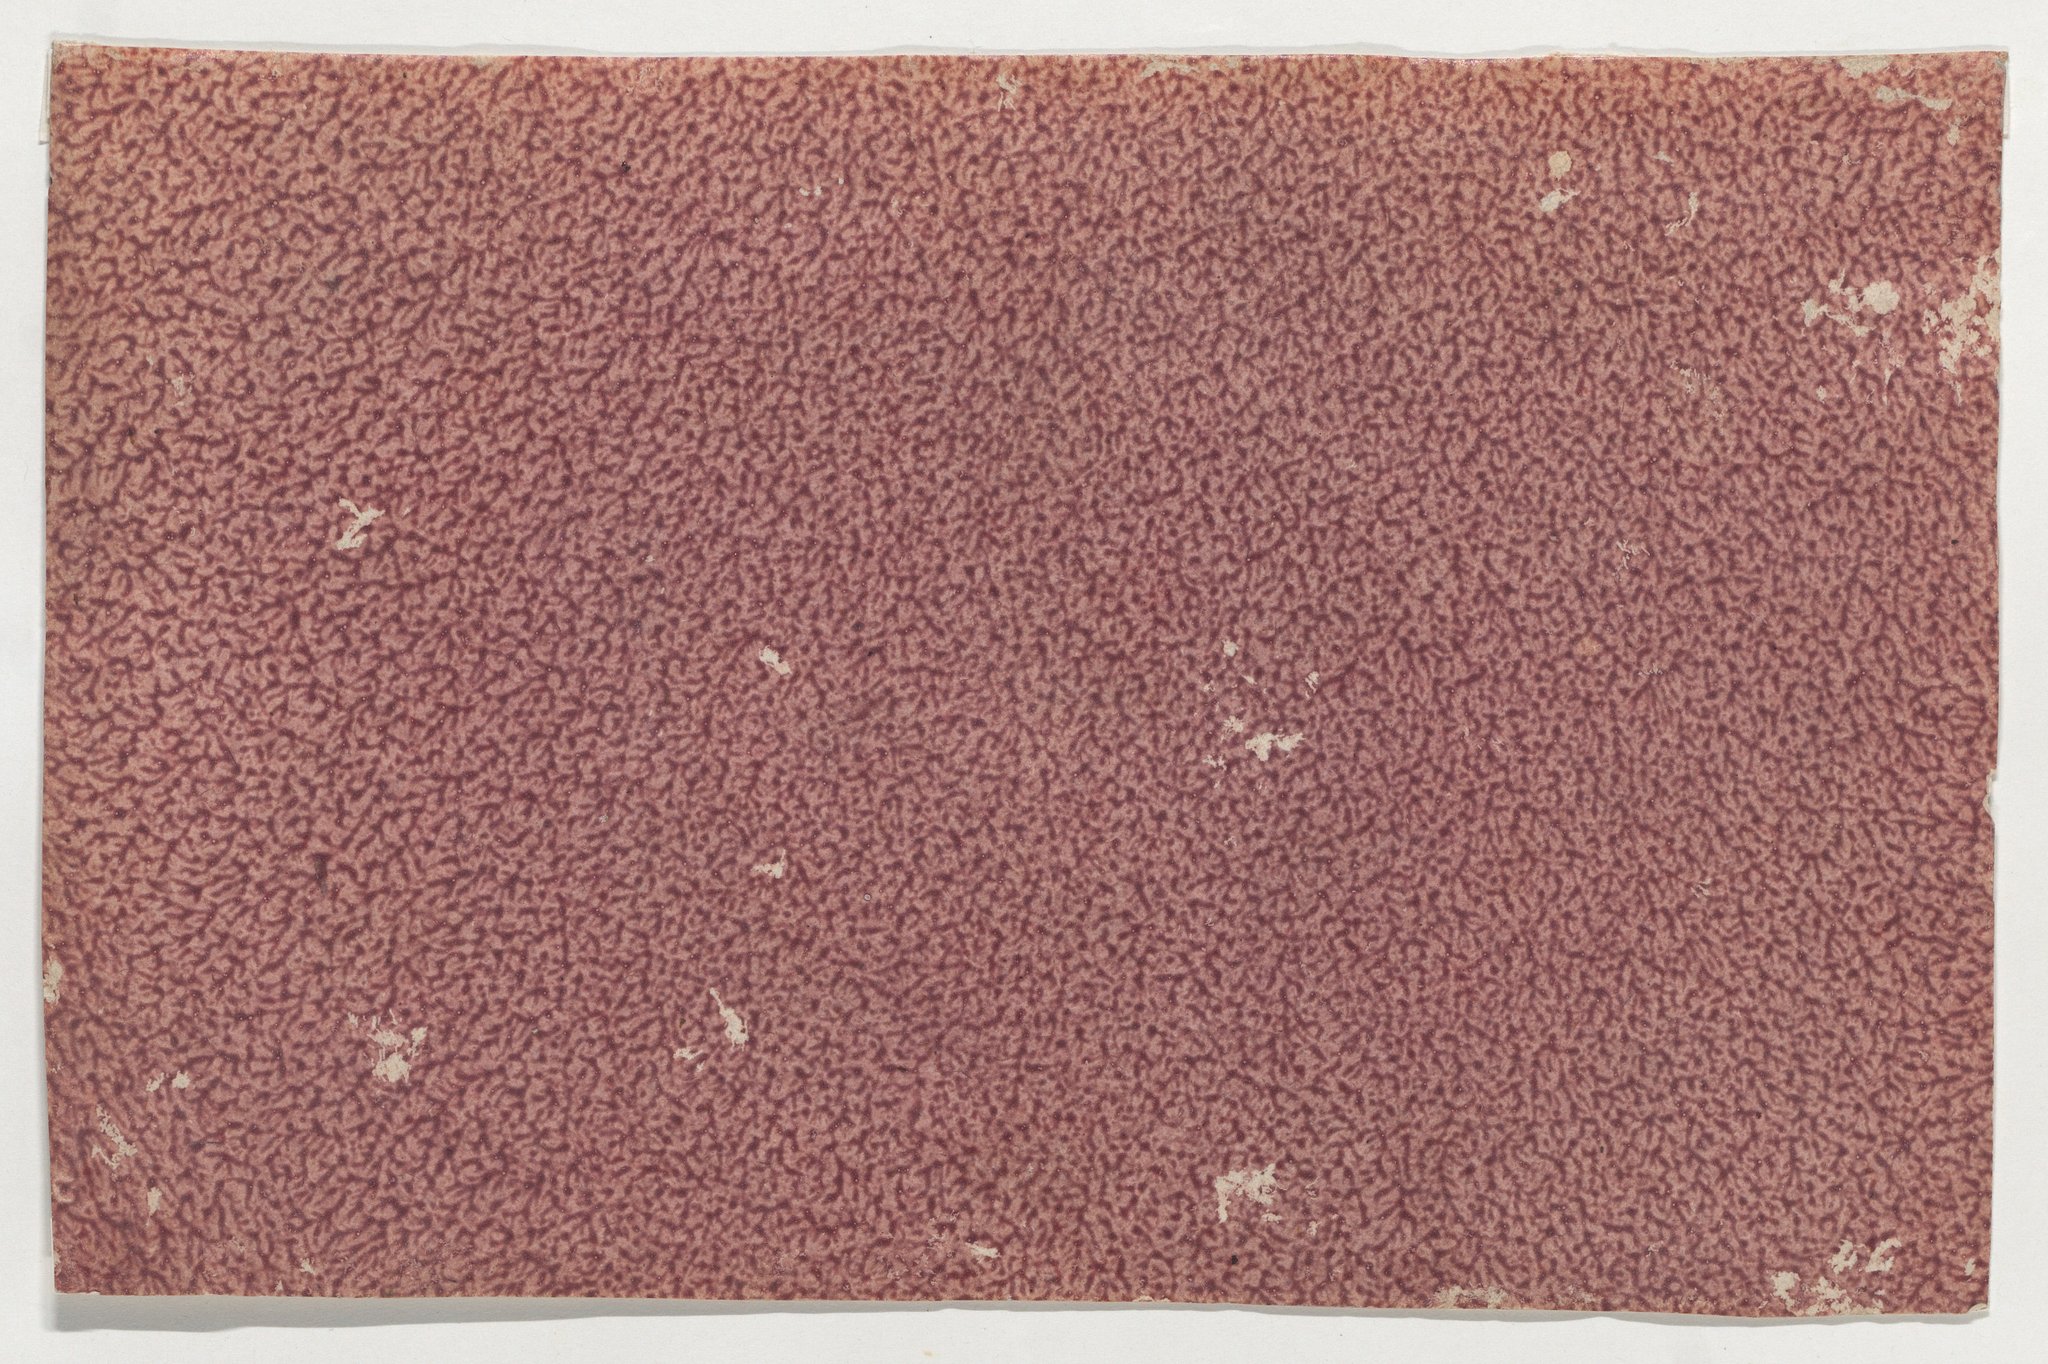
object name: print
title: Purple red paste paper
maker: Anonymous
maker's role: artist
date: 1701-1800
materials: paper, paste